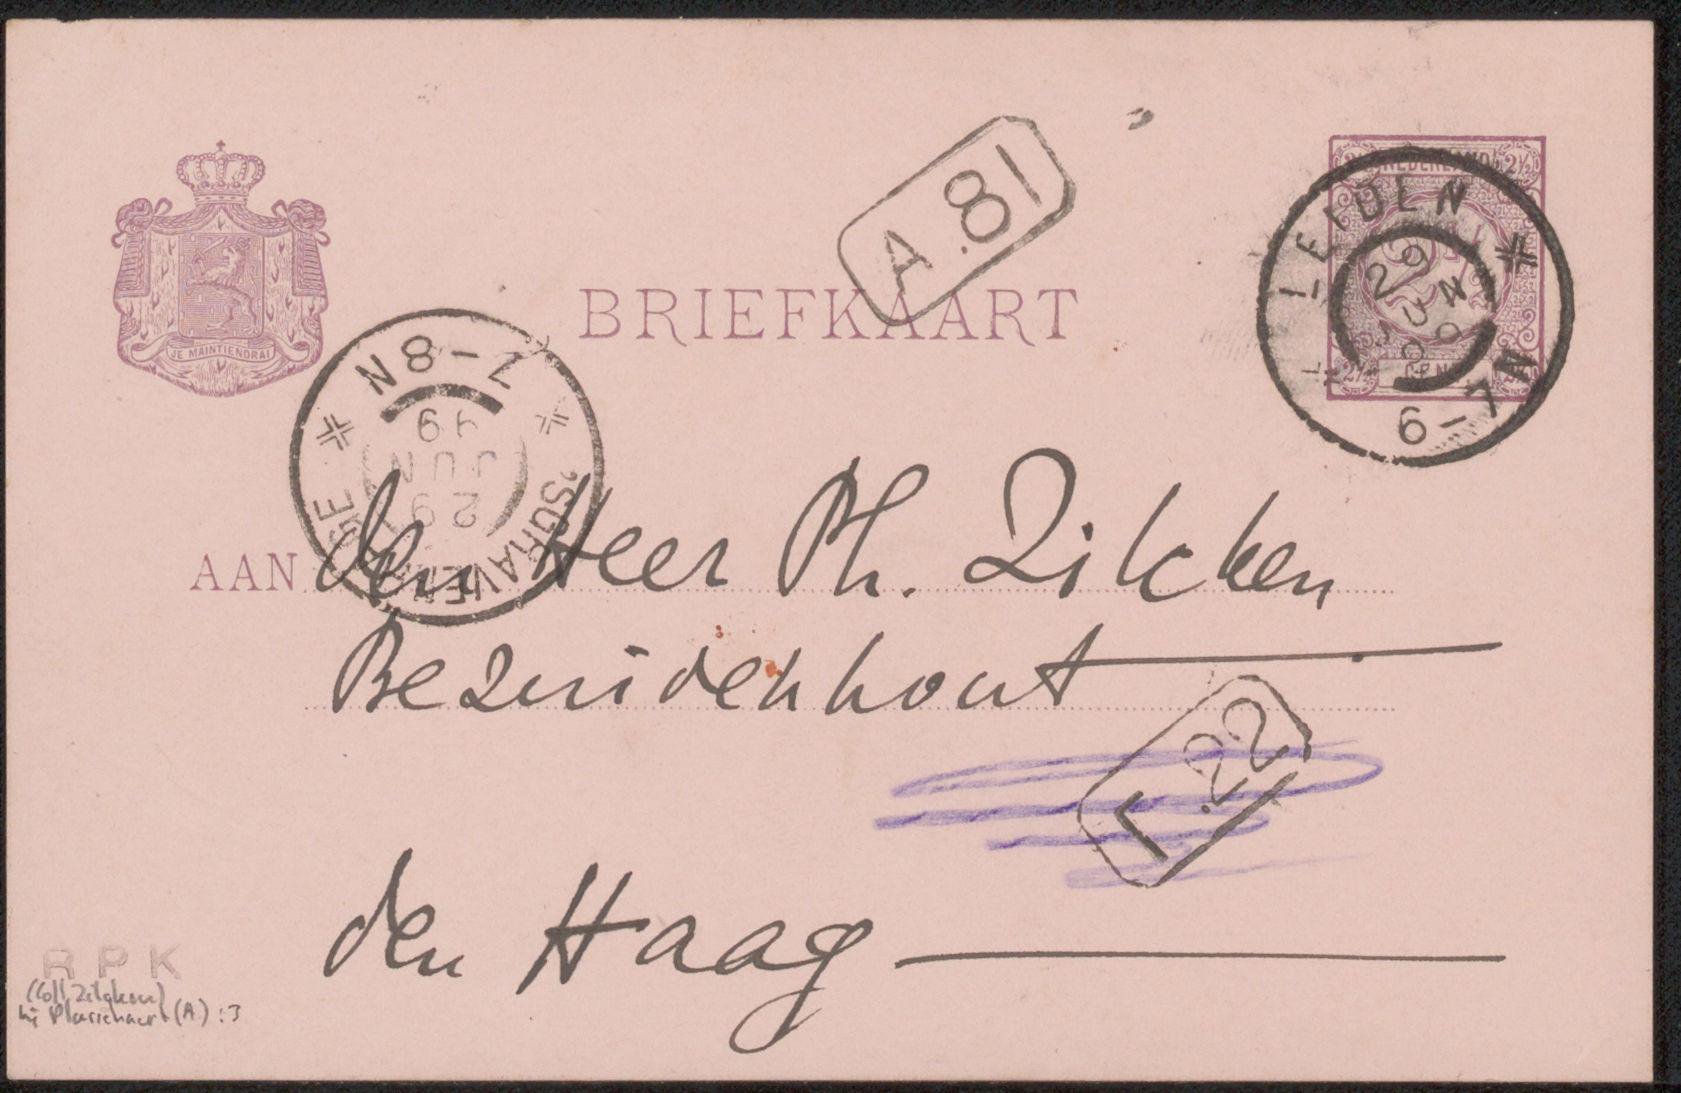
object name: postcard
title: Briefkaart aan Philip Zilcken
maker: albert plasschaert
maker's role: draughtsman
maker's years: 1866-1941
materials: cardboard, ink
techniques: pen, writing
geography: leiden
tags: the hague, painter, draughtsman, philip zilcken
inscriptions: collector's mark: ‘RPK’